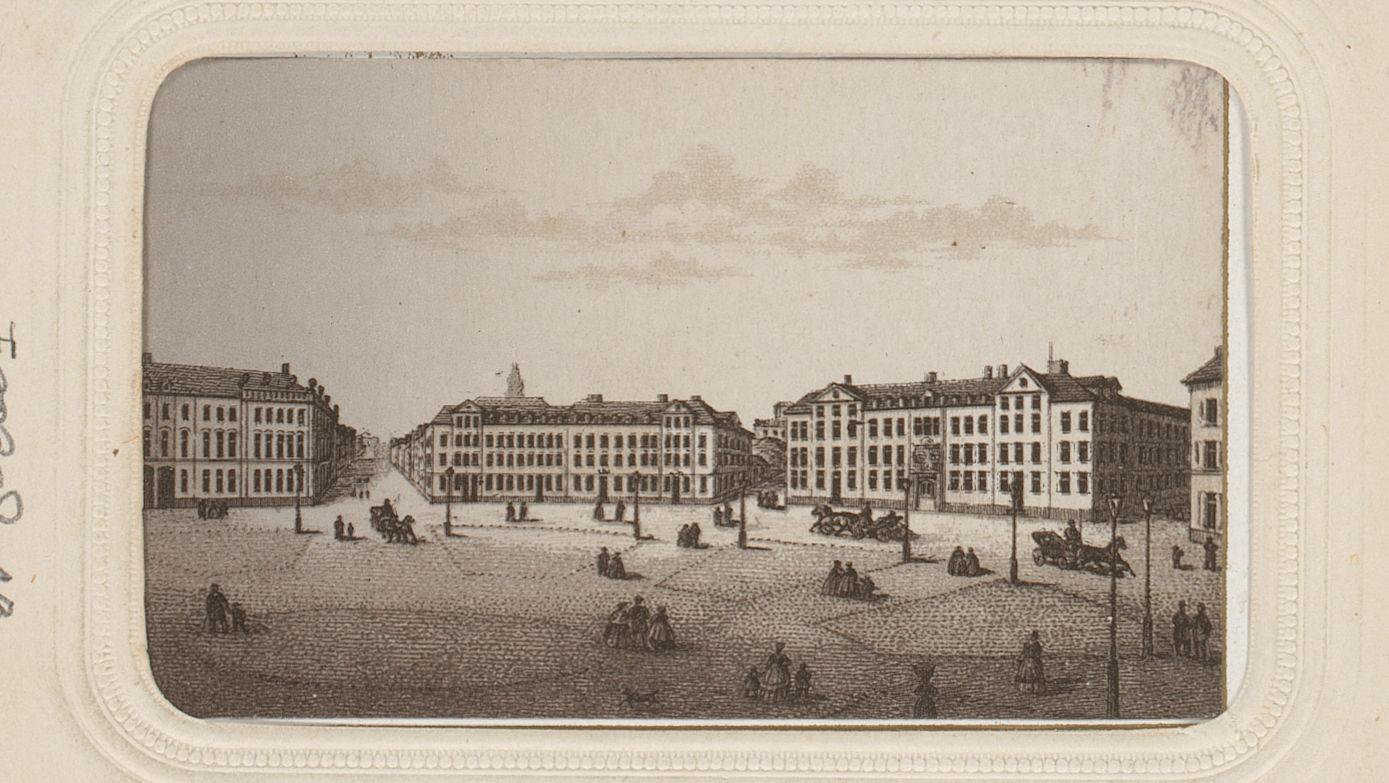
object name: reproduction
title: Fotoreproductie van Königsplatz te Kassel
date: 1860-1885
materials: cardboard, photographic support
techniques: collodion silver print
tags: square, place, circus, etc., civic architecture; edifices; dwellings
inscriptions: inscription: ‘Cassel Wilhelmshöhe’, annotation: ‘Cassel Königsplatz’